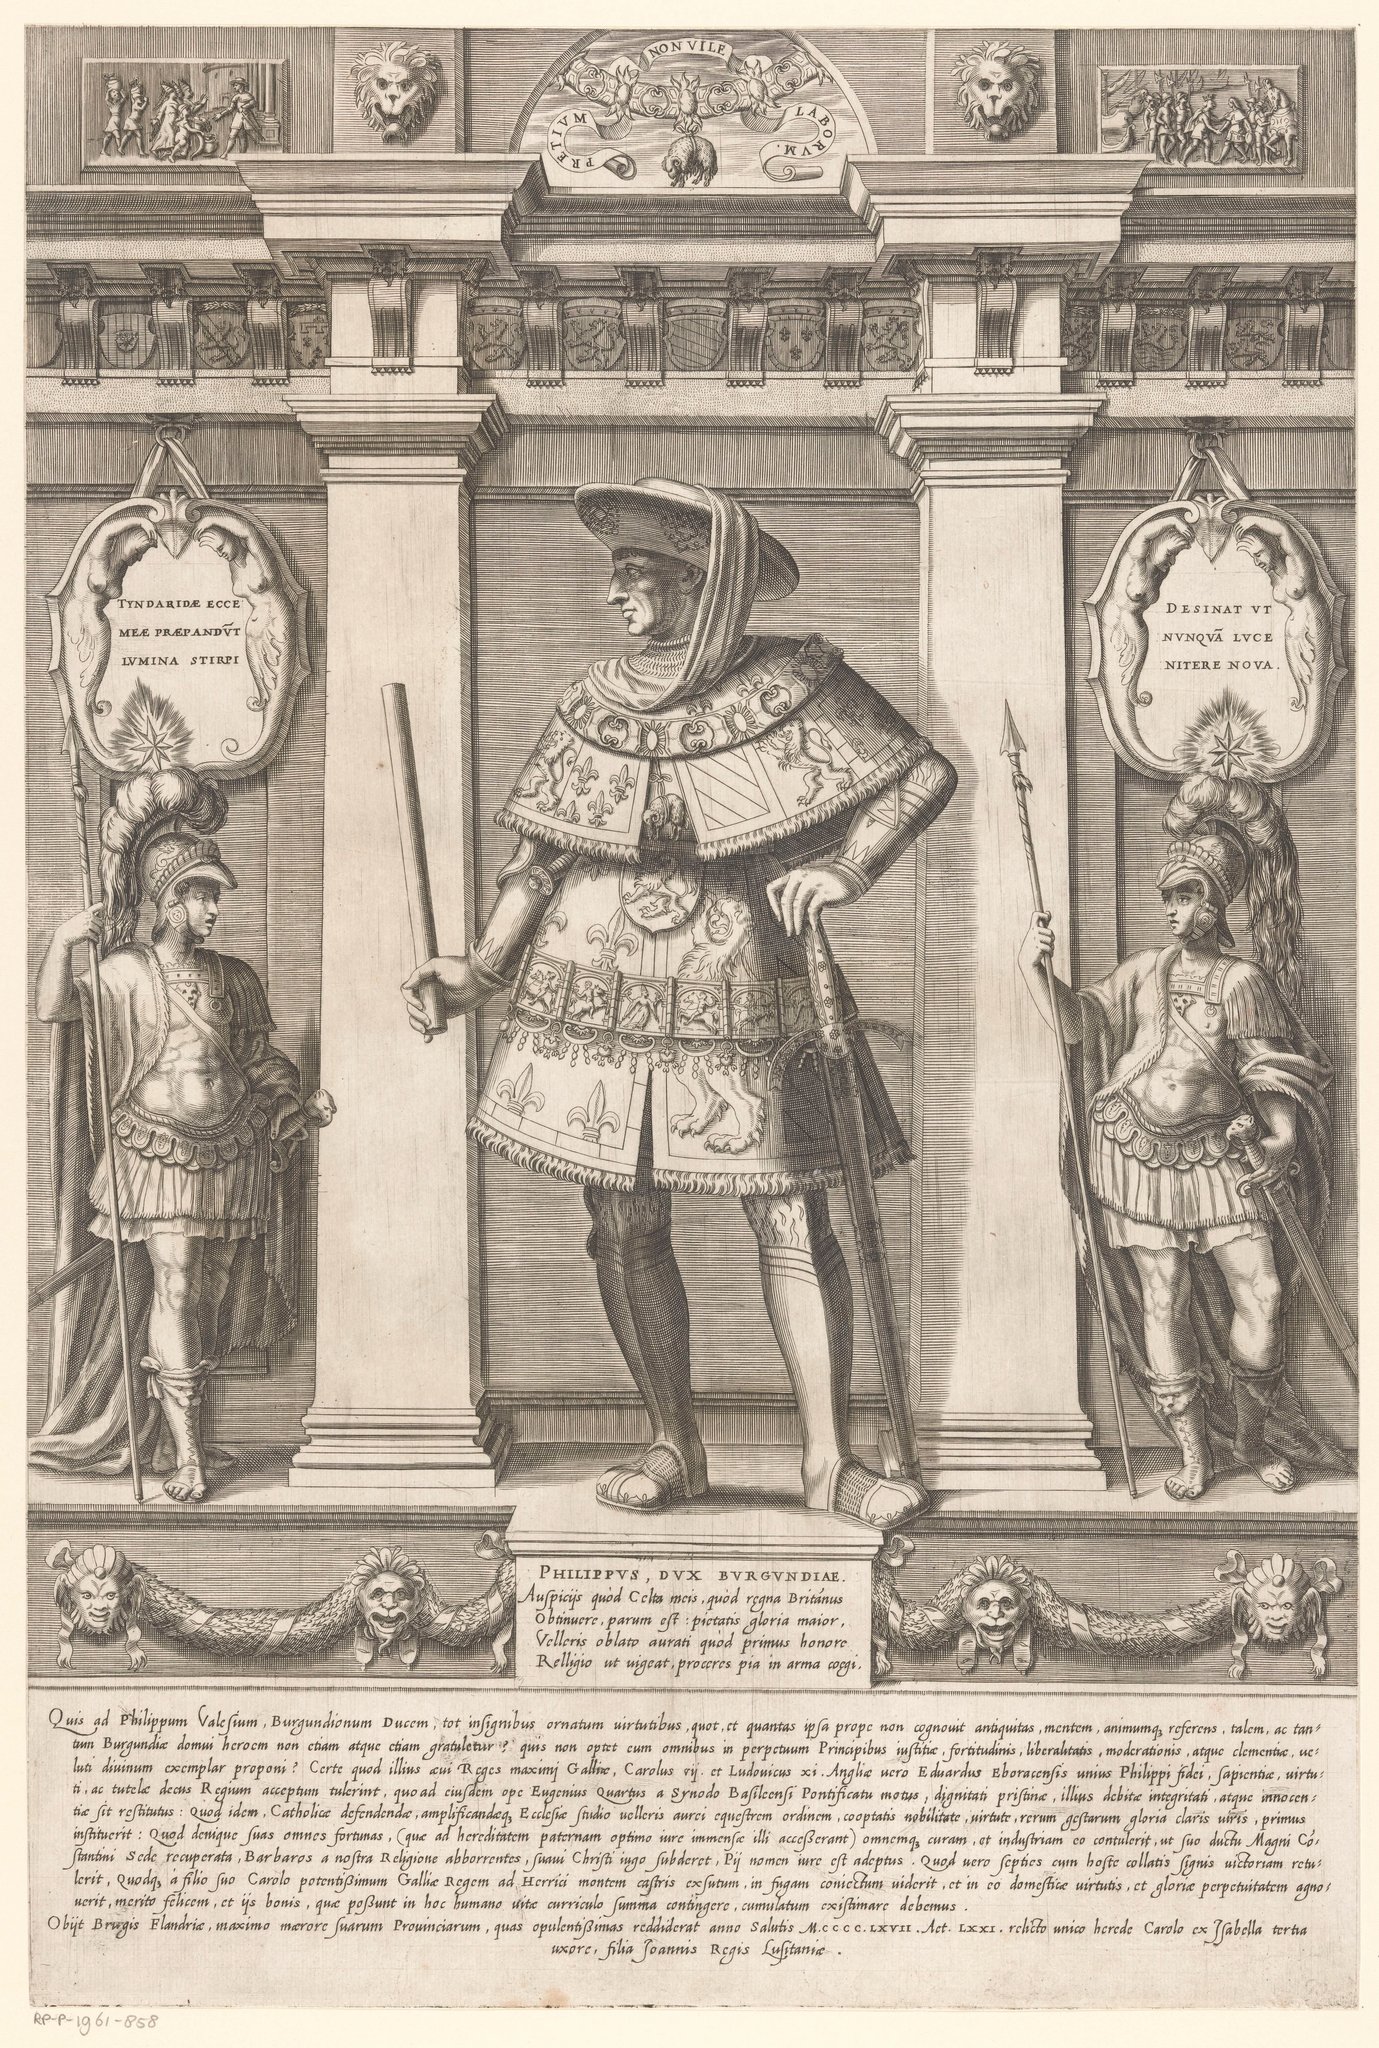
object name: print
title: Portret van Filips de Goede, hertog van Bourgondië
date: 1569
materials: paper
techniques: engraving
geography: italy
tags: philip iii the good, historical persons, ruler, sovereign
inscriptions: collector's mark: Lugt 2228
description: Deze prent maakt deel uit van een reeks van 58 prenten. Het meerendeel van de prenten bevat portretten van 74 leden van het Oostenrijkse Huis, naar tekeningen door Francesco Terzio, die deels getekend zijn naar de 28 levensgrote bronzen beelden die rond de cenotaaf van Maximiliaan I in de Hofkirche te Innsbruck staan.